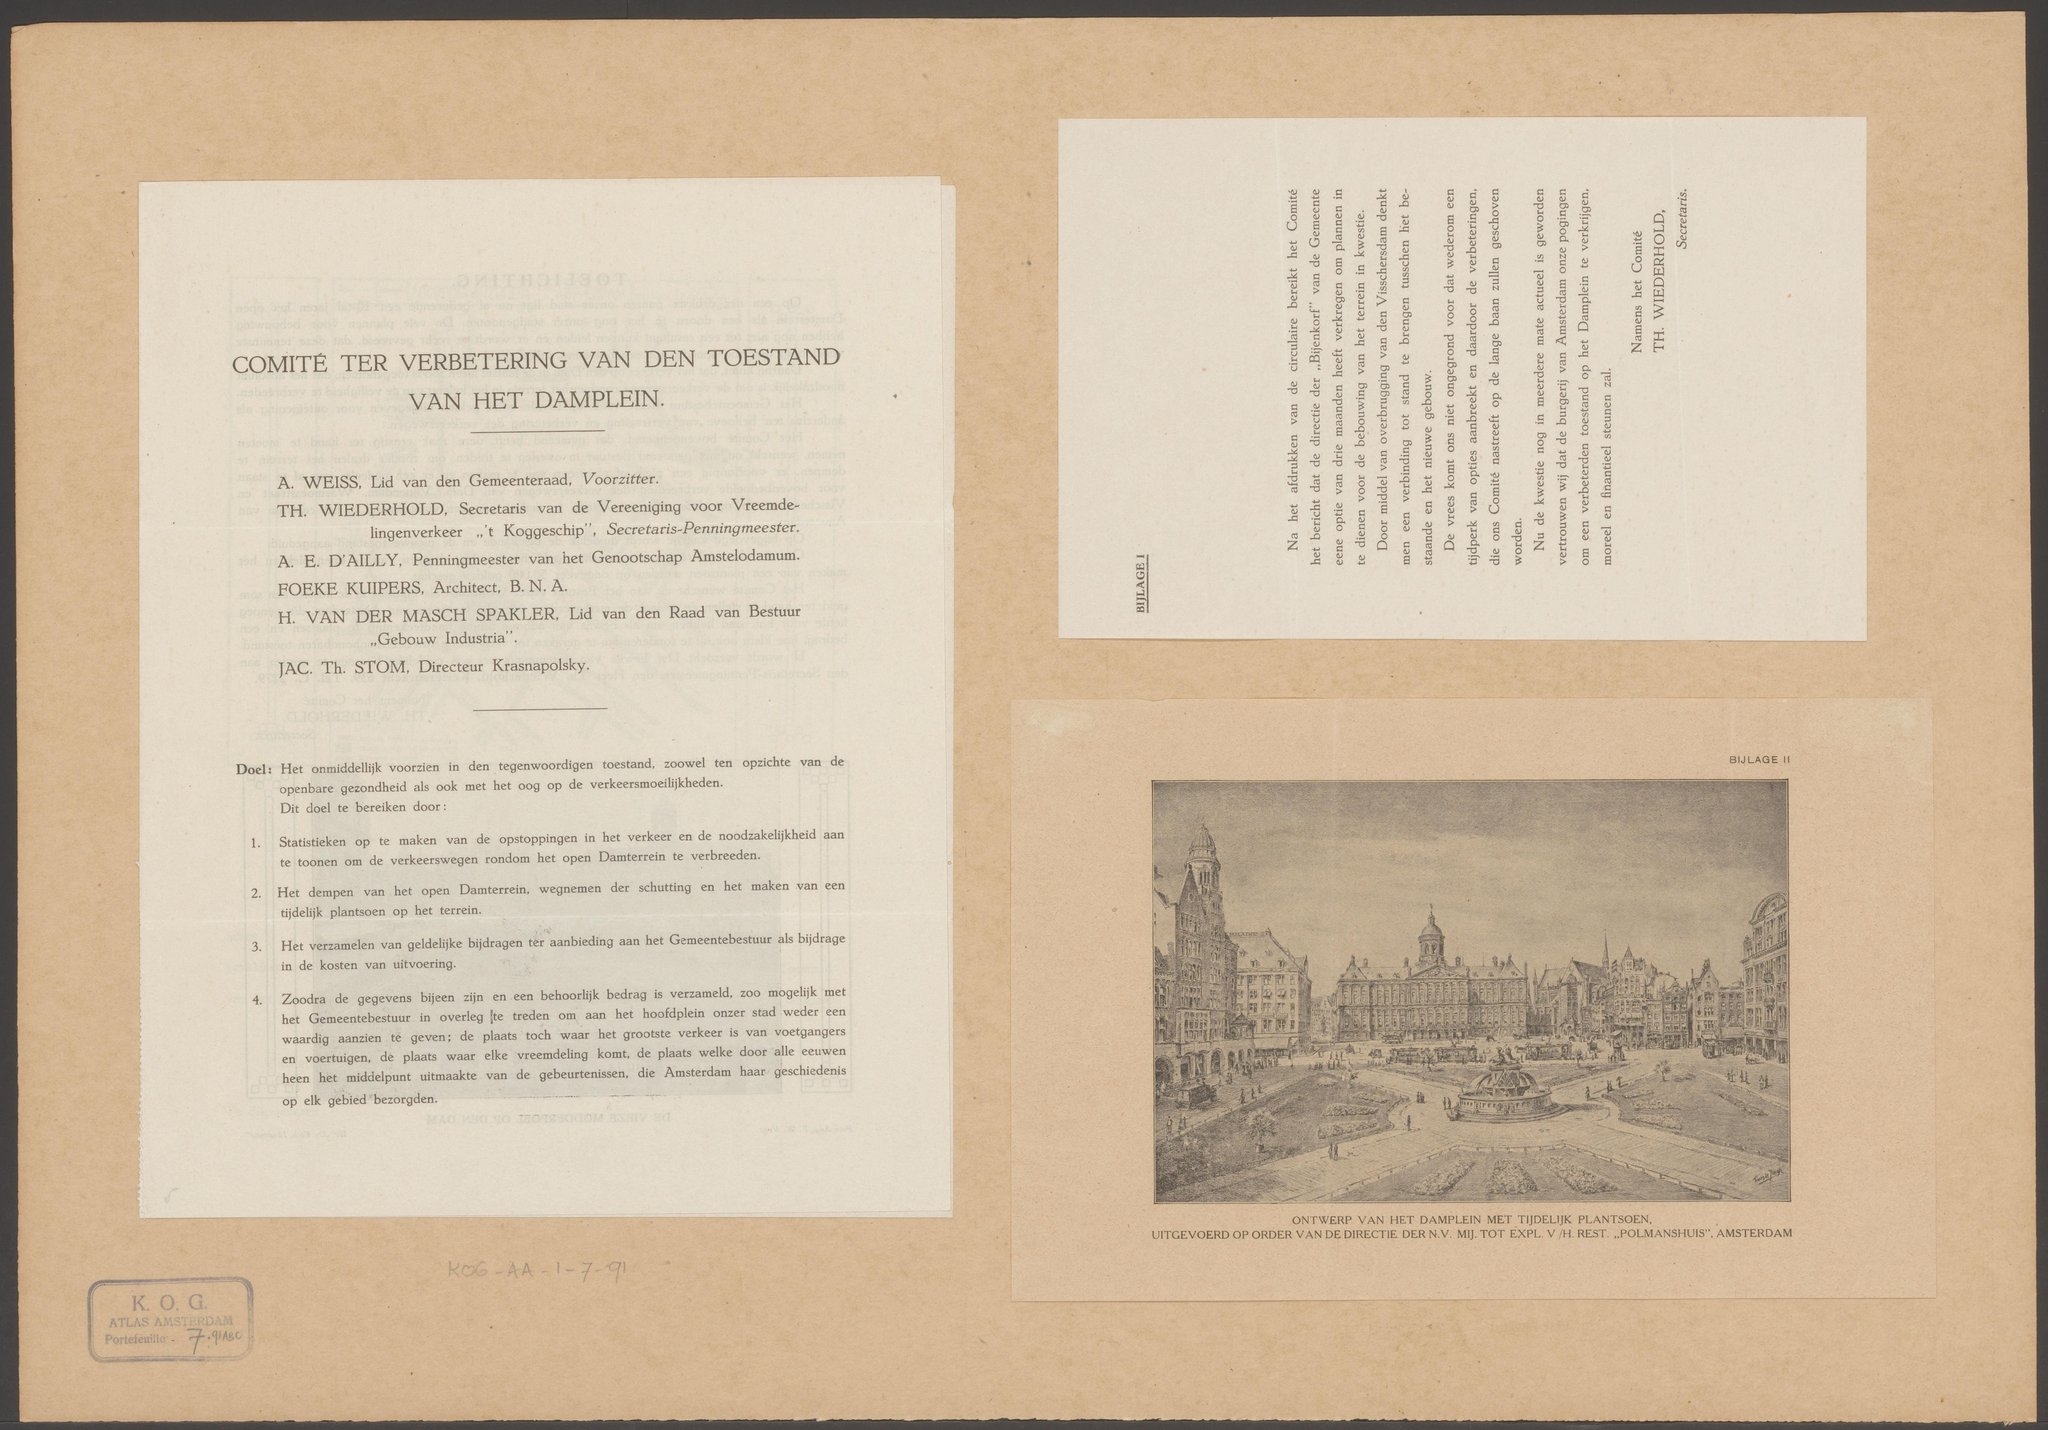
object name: design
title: Teksten voor donaties voor de verbouwing van het Damplein, de bouw van het pand van de Bijenkorf en een ontwerp voor een tijdelijk plantsoen op de Dam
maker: Anonymous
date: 1920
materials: paper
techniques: letterpress printing, line block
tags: square, place, circus, etc., city-view in general; 'veduta', façade (of house or building)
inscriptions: collector's mark: ‘7’ Lugt 1641b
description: Onderwerpsrubriek binnen de Atlas Amsterdam: Dam (na 1835).